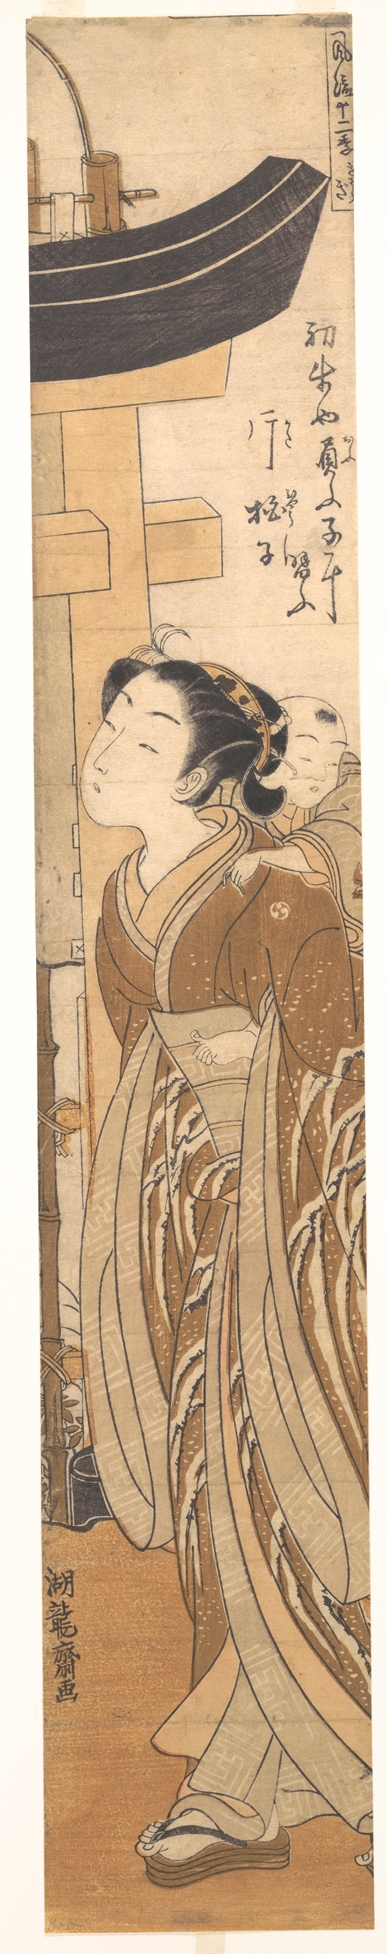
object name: print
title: A Woman Carrying a Child on Her Back near the Entrance to a Temple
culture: japanese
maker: isoda koryūsai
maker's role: artist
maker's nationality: japanese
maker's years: 1735-1790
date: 1770-1790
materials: ink, paper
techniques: woodblock print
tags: children,women